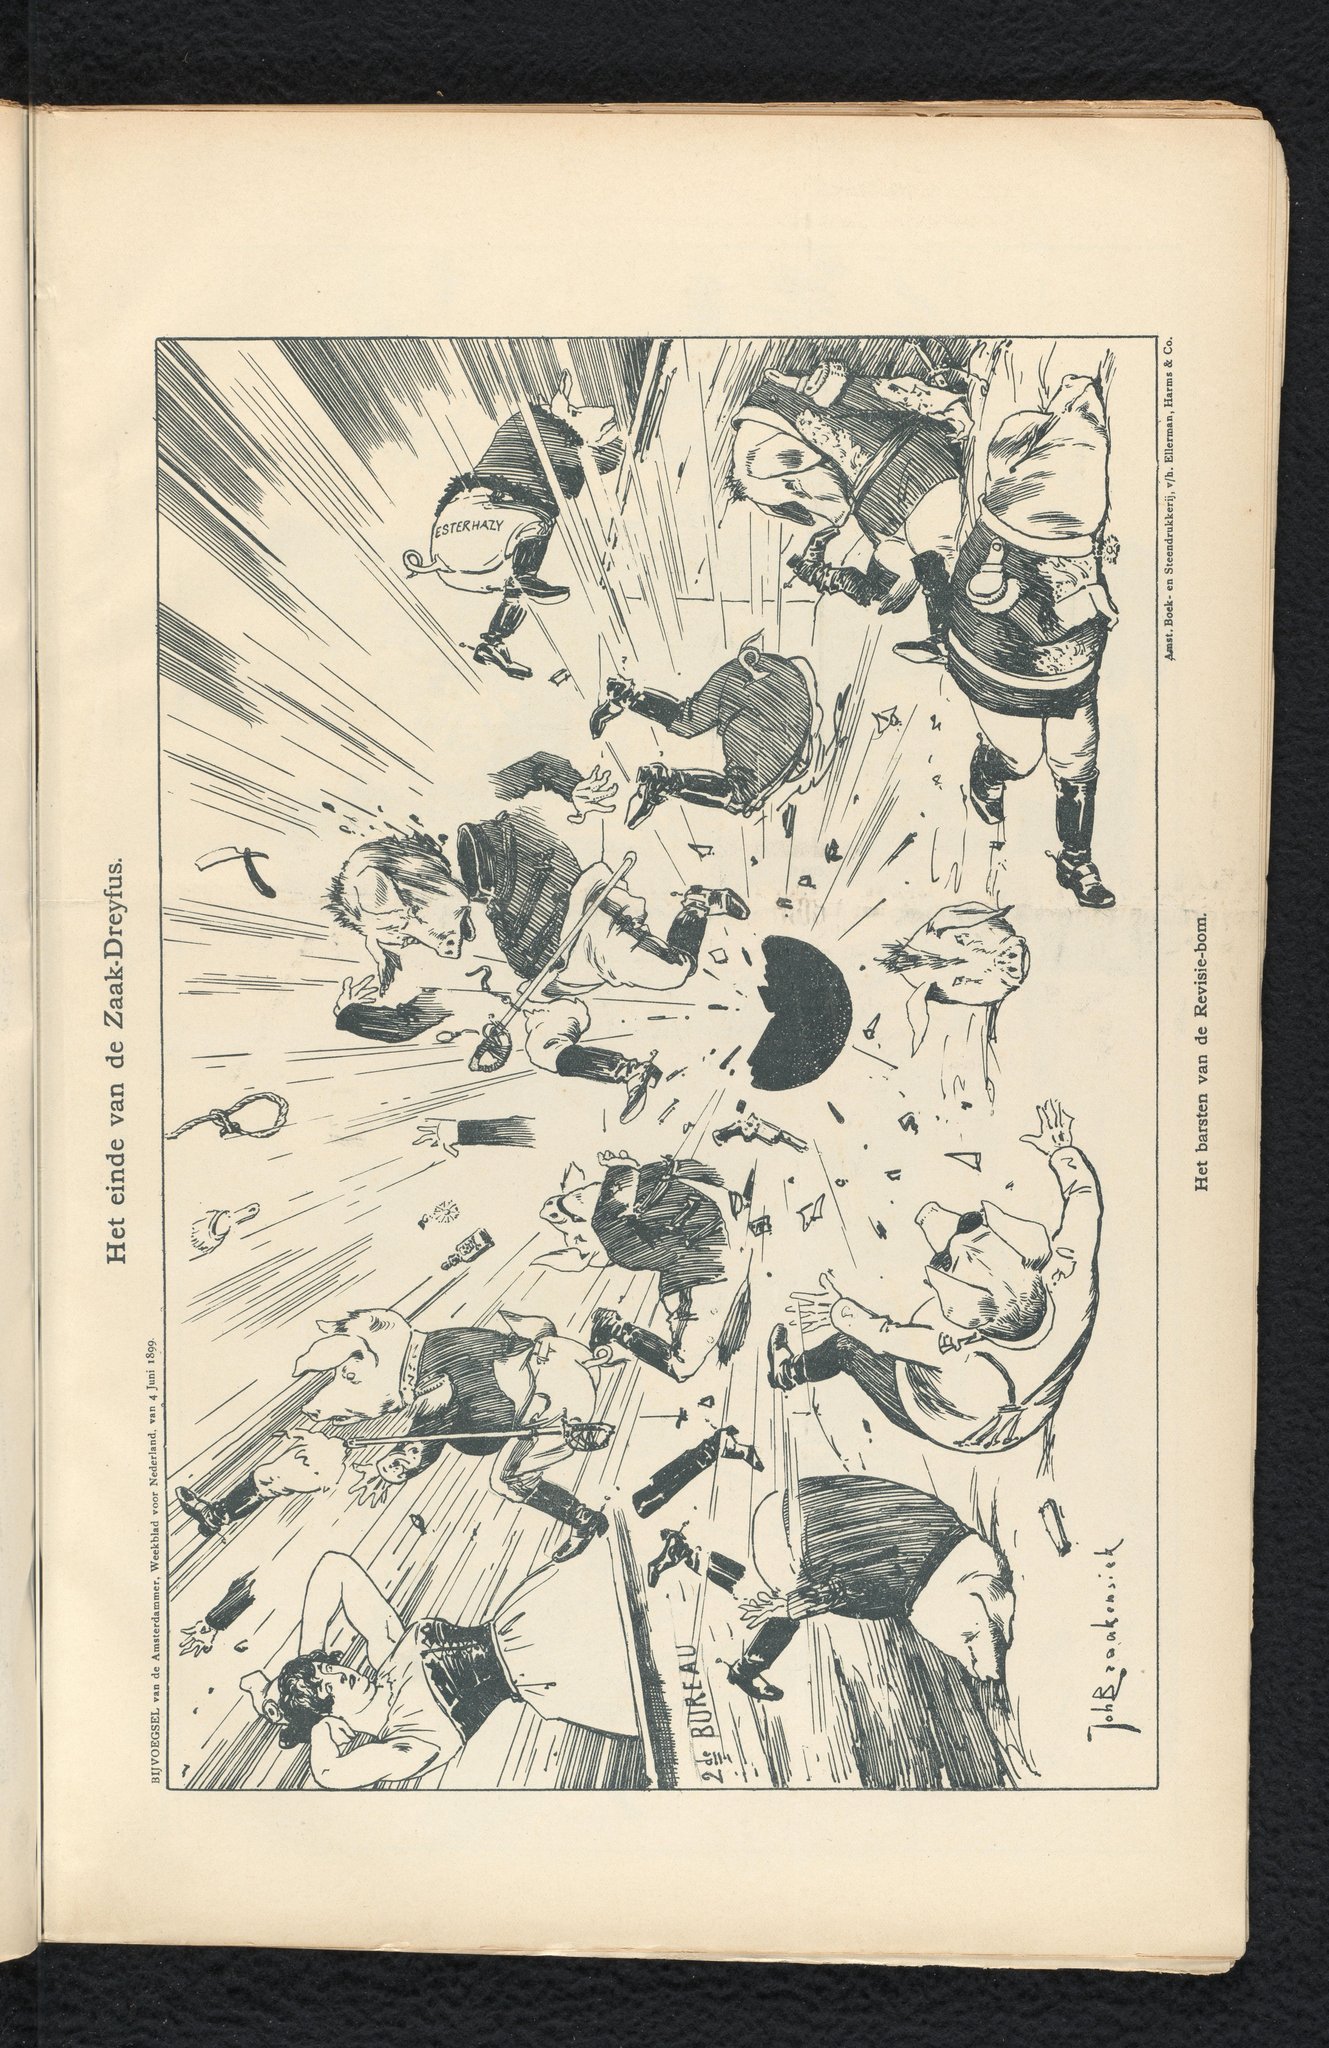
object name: cartoon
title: Het einde van de Zaak-Dreyfus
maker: johan braakensiek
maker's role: draughtsman, print maker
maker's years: 1858-1940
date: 1899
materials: paper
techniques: lithograph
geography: netherlands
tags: pig, personifications of countries, nations, states, districts, etc., violent death by bomb, hand-grenade, projectiles, explosives, etc. (with name), political caricatures and satires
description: Marianne (Frankrijk) ziet verschrikt toe hoe de Dreyfusaffaire als een bom ontploft en Franse militairen als varkens in stukken die alle kanten uitvliegen.